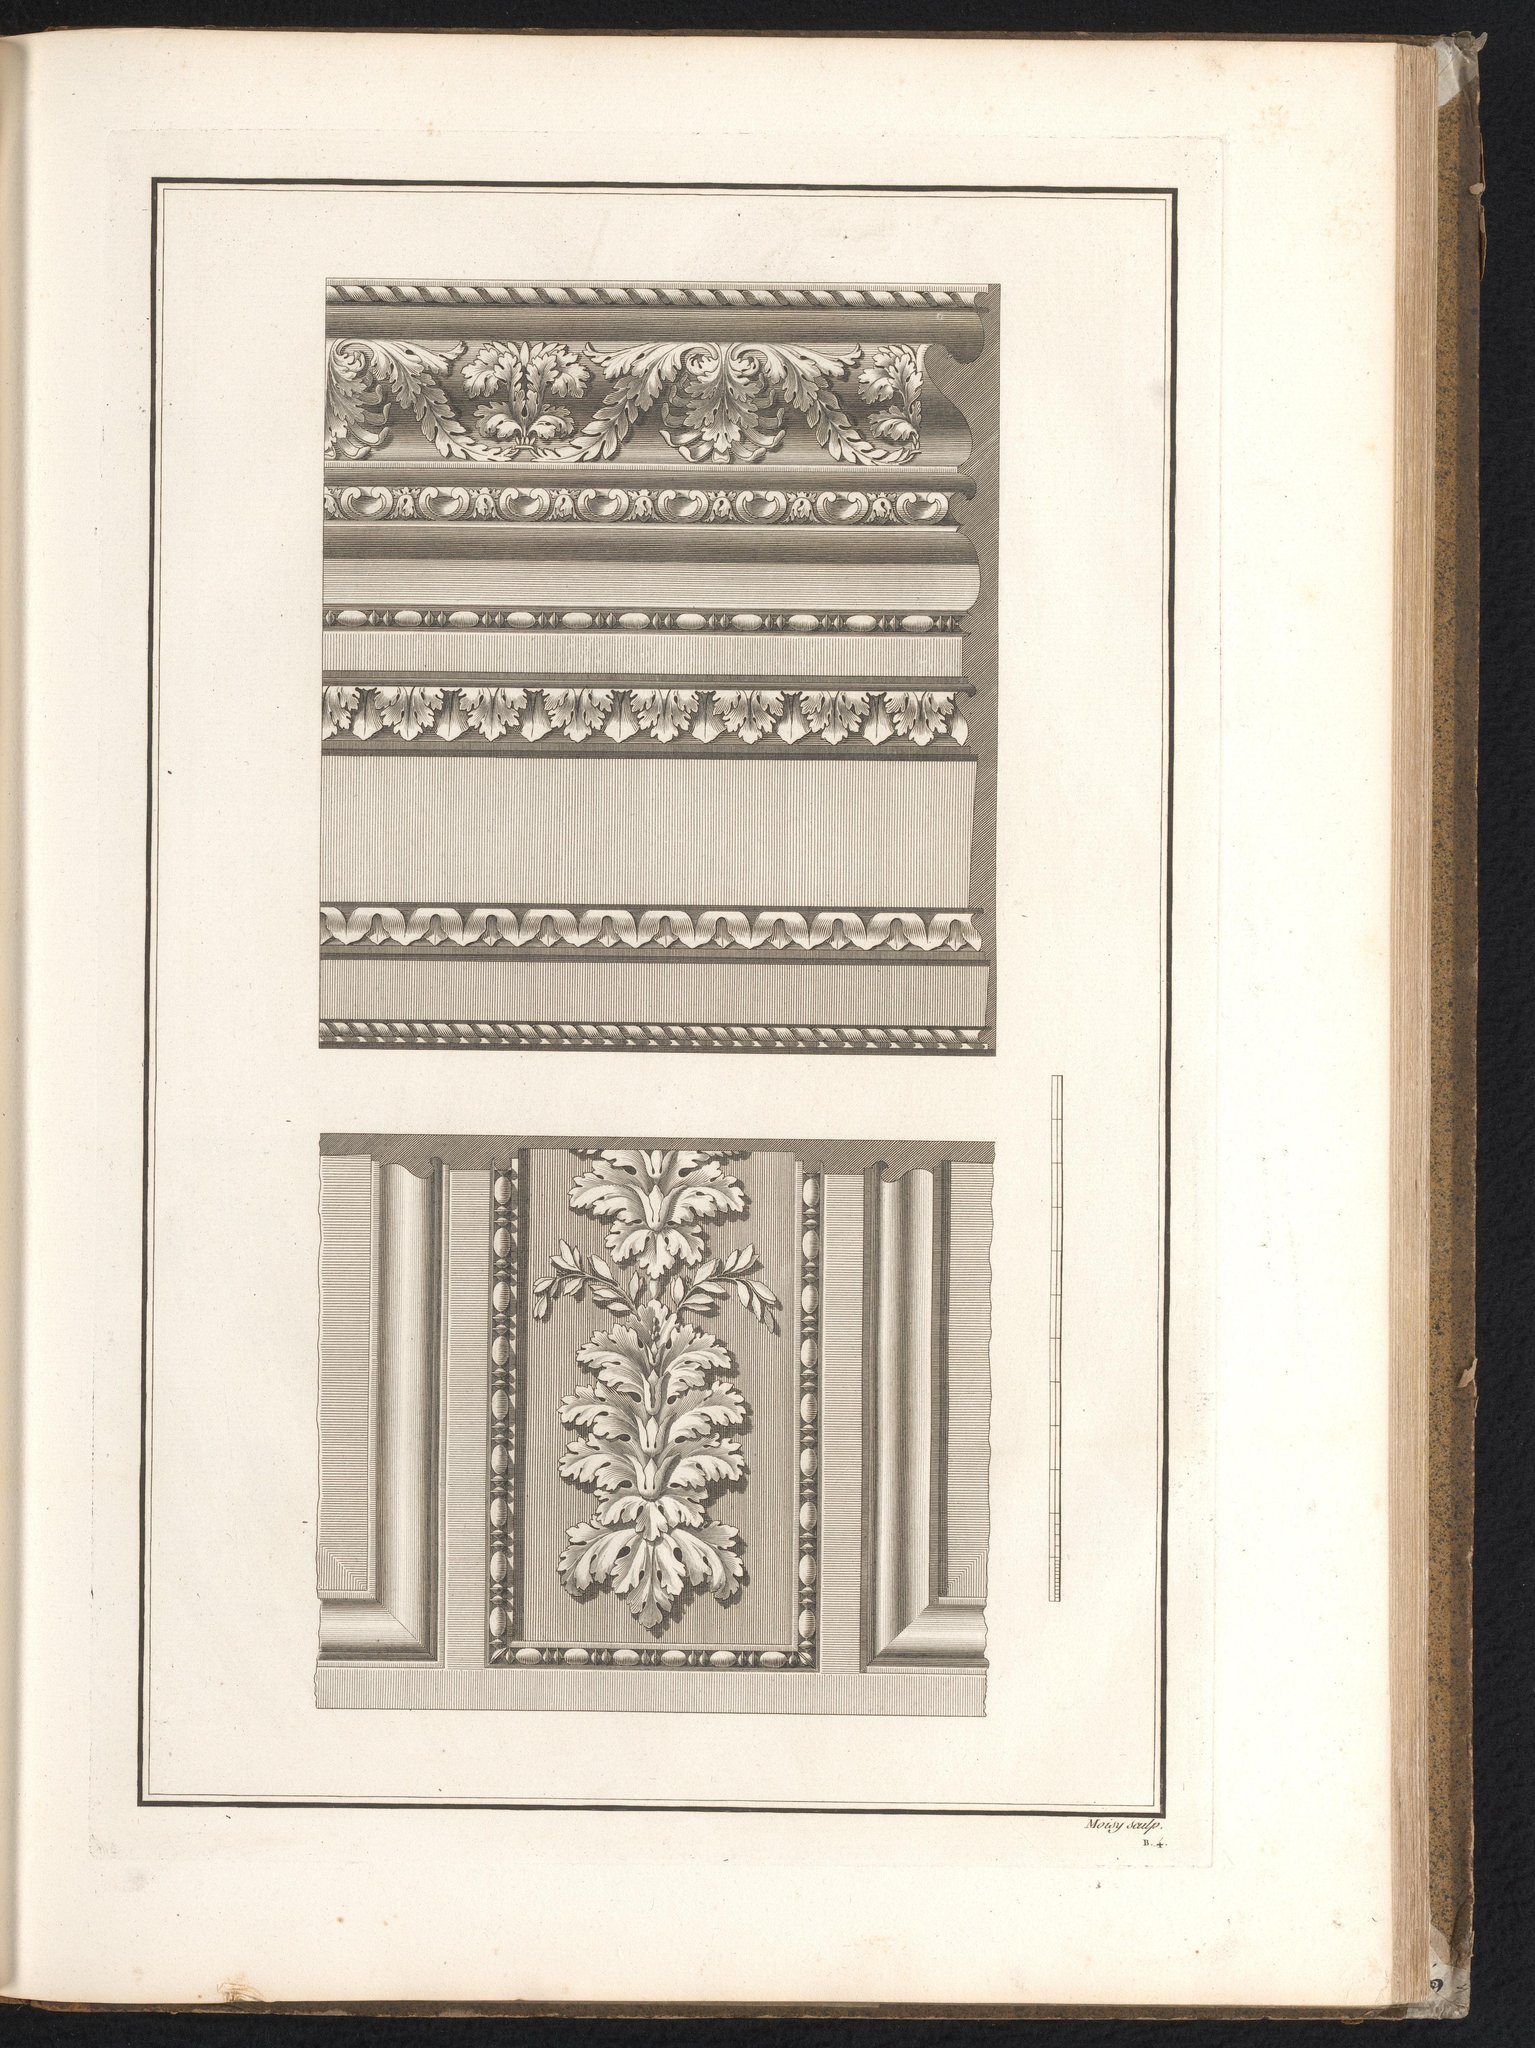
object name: print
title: Modèles de plafonds, corniches, profils, fragments et détails d'ornements, tirés des plus beaux edifices modernes d'Italie à l'usage des artistes : deuxième cahier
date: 1792-1802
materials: paper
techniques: engraving, etching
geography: paris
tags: decorations (interior of the house), ornament derived from plant forms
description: Doordat dit album bestaat uit meerdere, deels eerder uitgegeven prentreeksen, is de datering niet consequent. Het geheel is op de titelpagina gedateerd op 1802. Deze reeks is gedateerd 1792. Aangezien onduidelijk is wanneer de prenten in deze vorm precies uitgegeven zijn, worden beide data gehanteerd: zowel 1802 als publicatiedatum, en de eerdere datum. De serietitel voor het gehele werk is "Recueil d'arabesques, contenant les loges du Vatican". De andere serietitel is de titel van de specifieke reeks binnen het geheel.